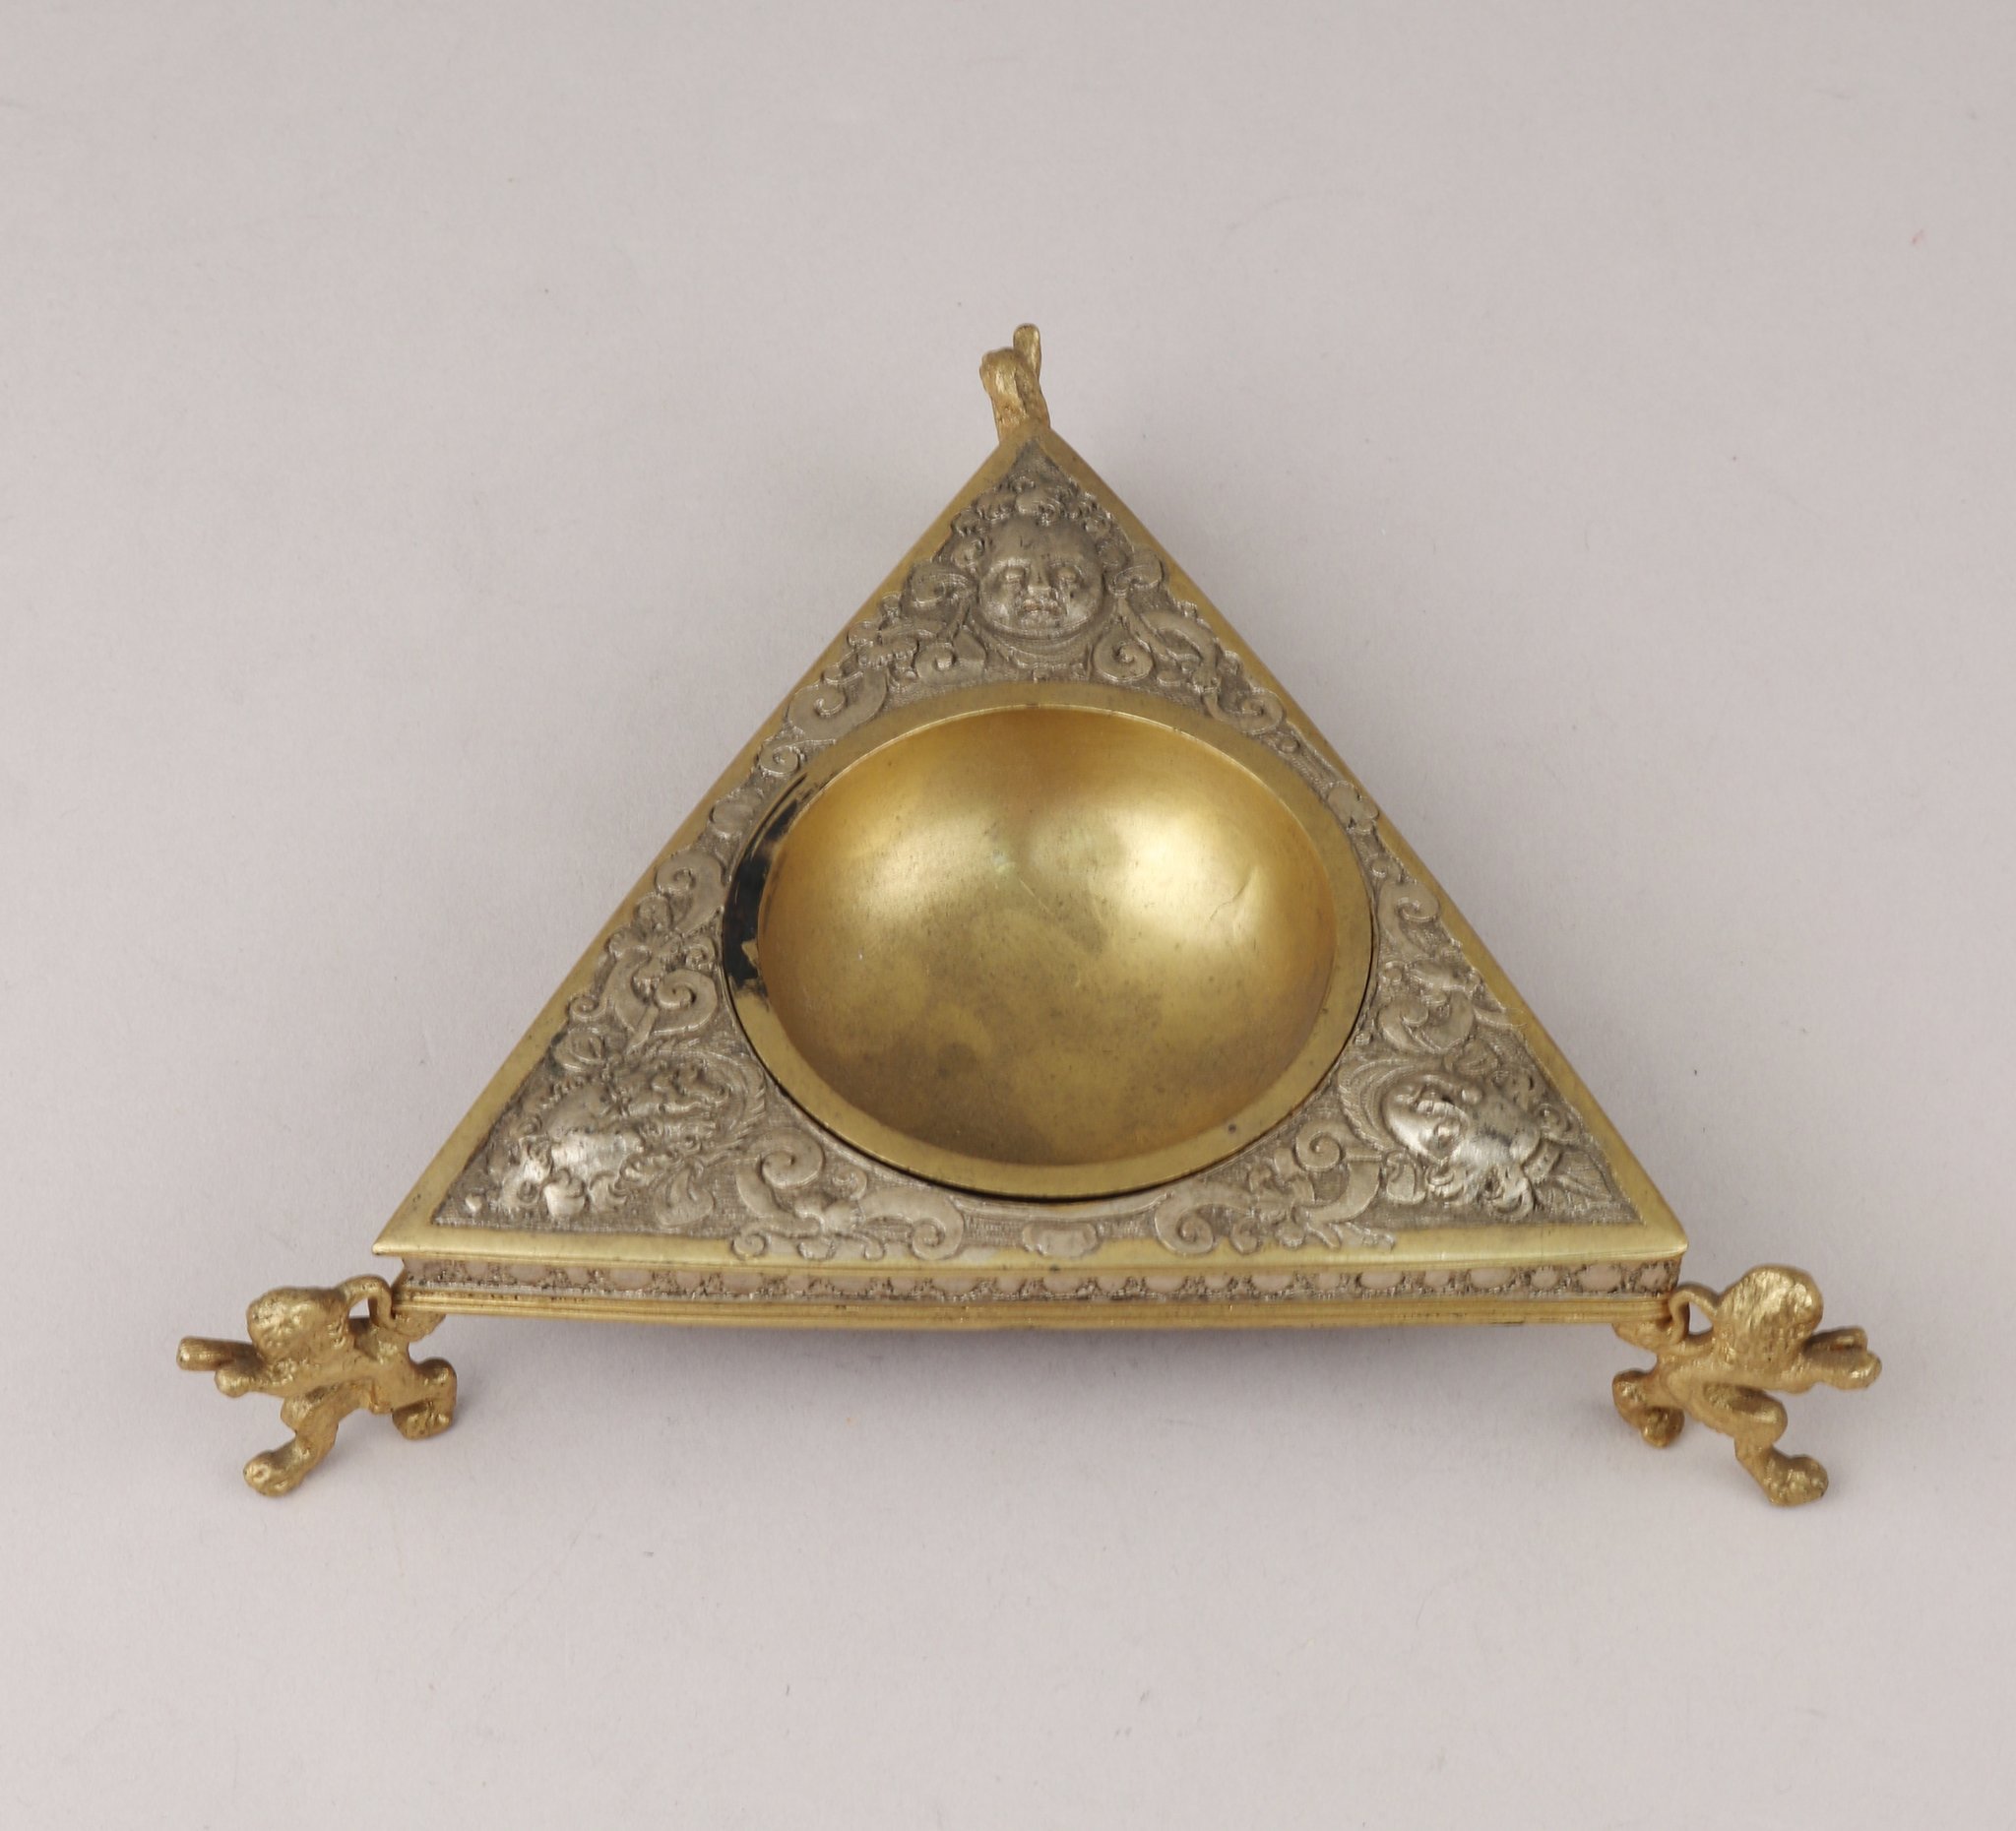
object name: saltcellar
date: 1801-1900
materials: metal, silver